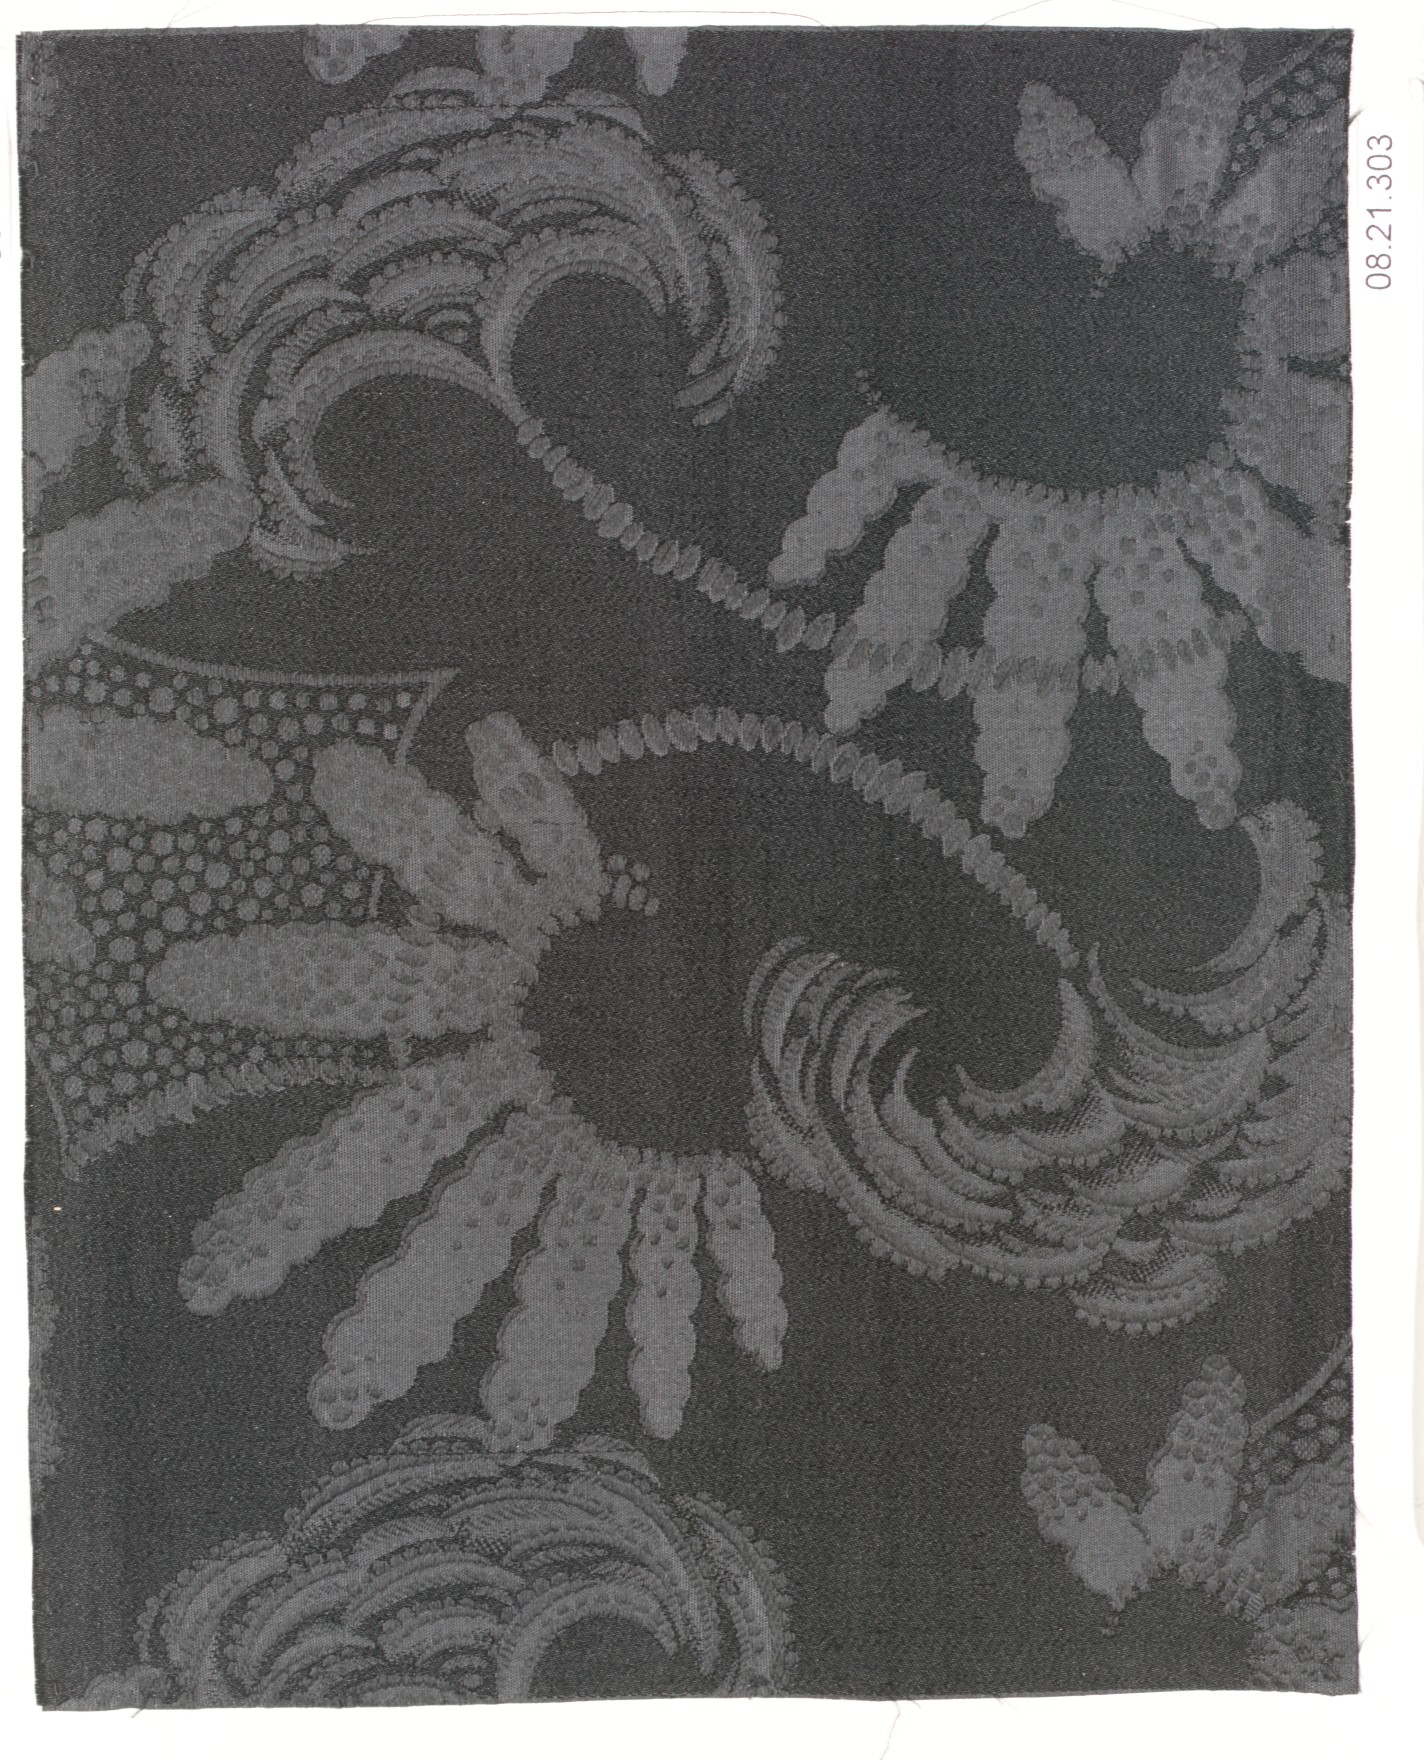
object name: textile sample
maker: Anonymous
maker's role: designer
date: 1900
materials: silk